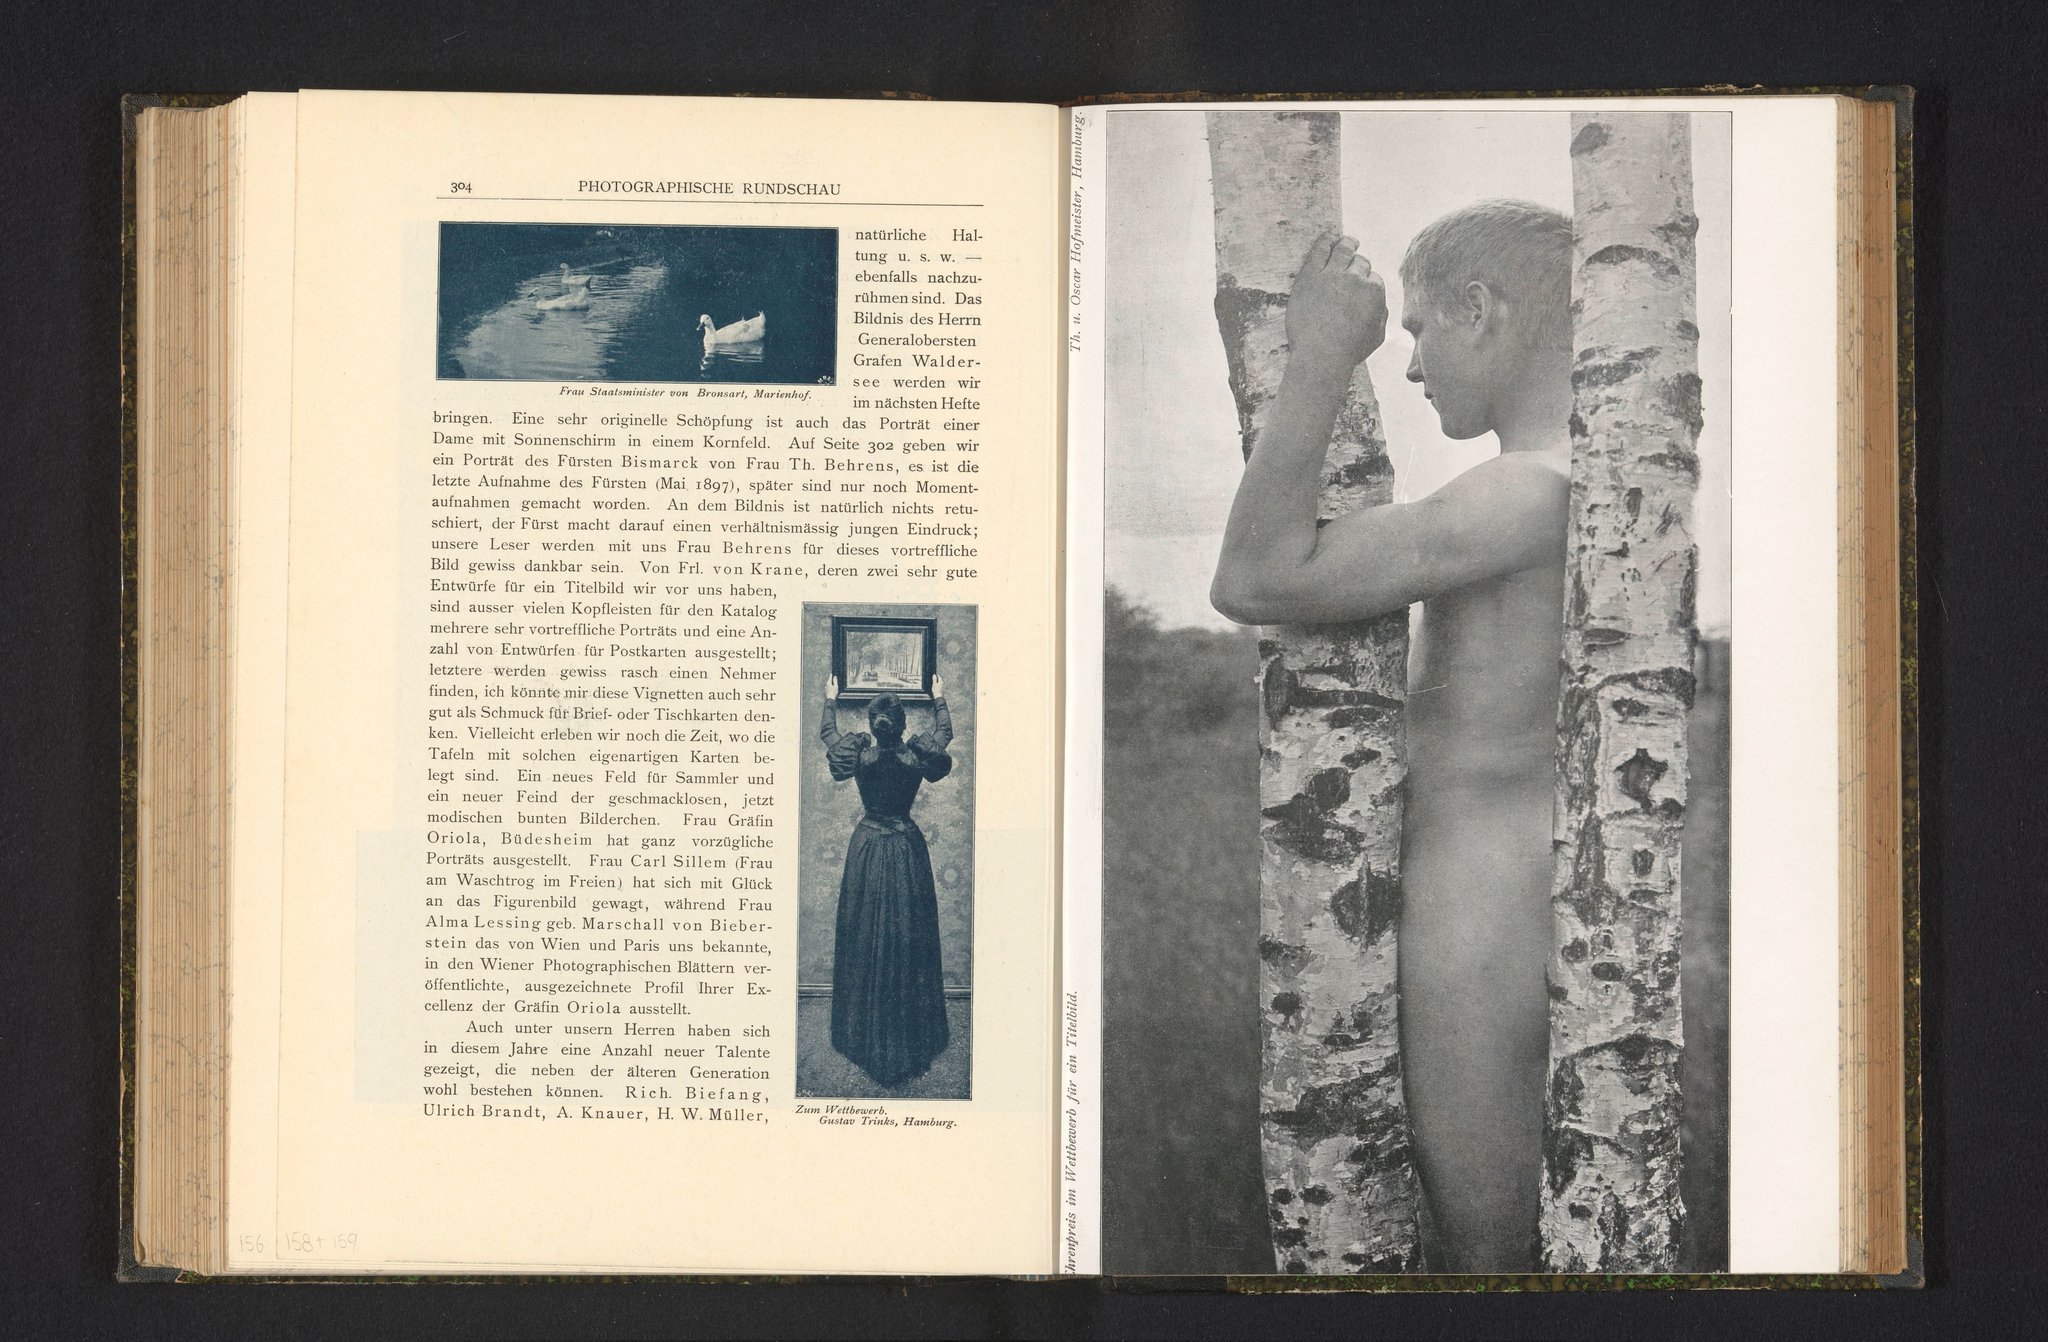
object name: photomechanical print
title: Gezicht op eenden in het water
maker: harriet helene von bronsart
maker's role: fotograaf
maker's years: 1845-1917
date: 1893-1898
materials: paper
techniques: autotype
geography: berlin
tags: water-birds: duck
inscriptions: monogram: ‘MR&C’